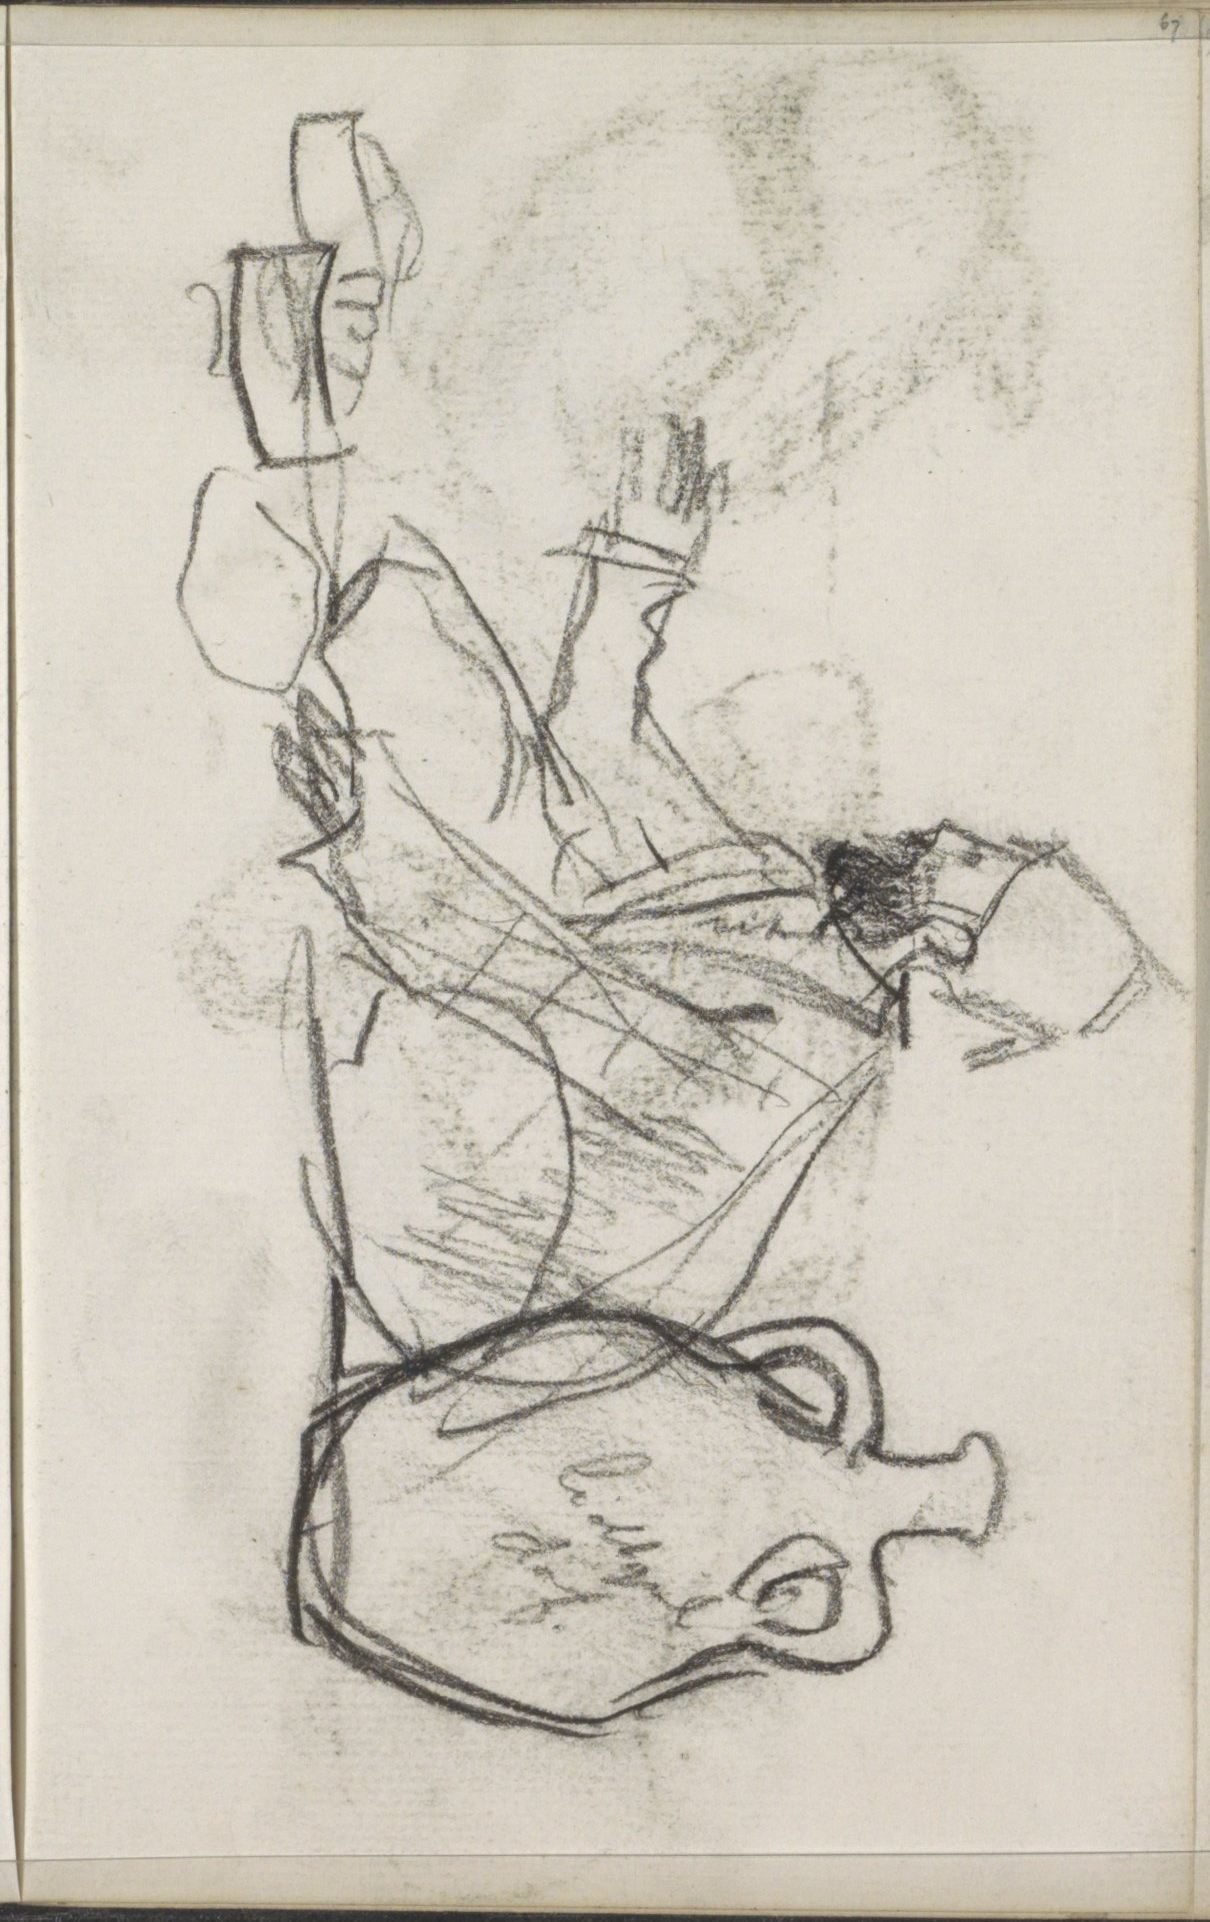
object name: sketchbook leaf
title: Oosterse man, zittend bij een kruik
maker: marius bauer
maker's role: draughtsman, print maker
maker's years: 1867-1932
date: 1899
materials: chalk, paper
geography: turkey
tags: asiatic races and peoples, sitting figure, container of ceramics: jar, jug, pot, vase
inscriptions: kleurnotitie, handgeschreven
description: Pagina 67 uit een schetsboek met 42 bladen.